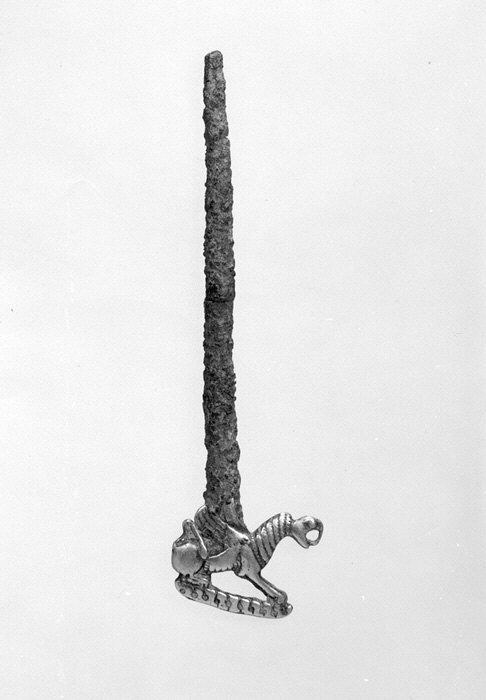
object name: pin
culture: bactria-margiana archaeological complex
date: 2333-1668 BCE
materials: silver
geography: bactria-margiana